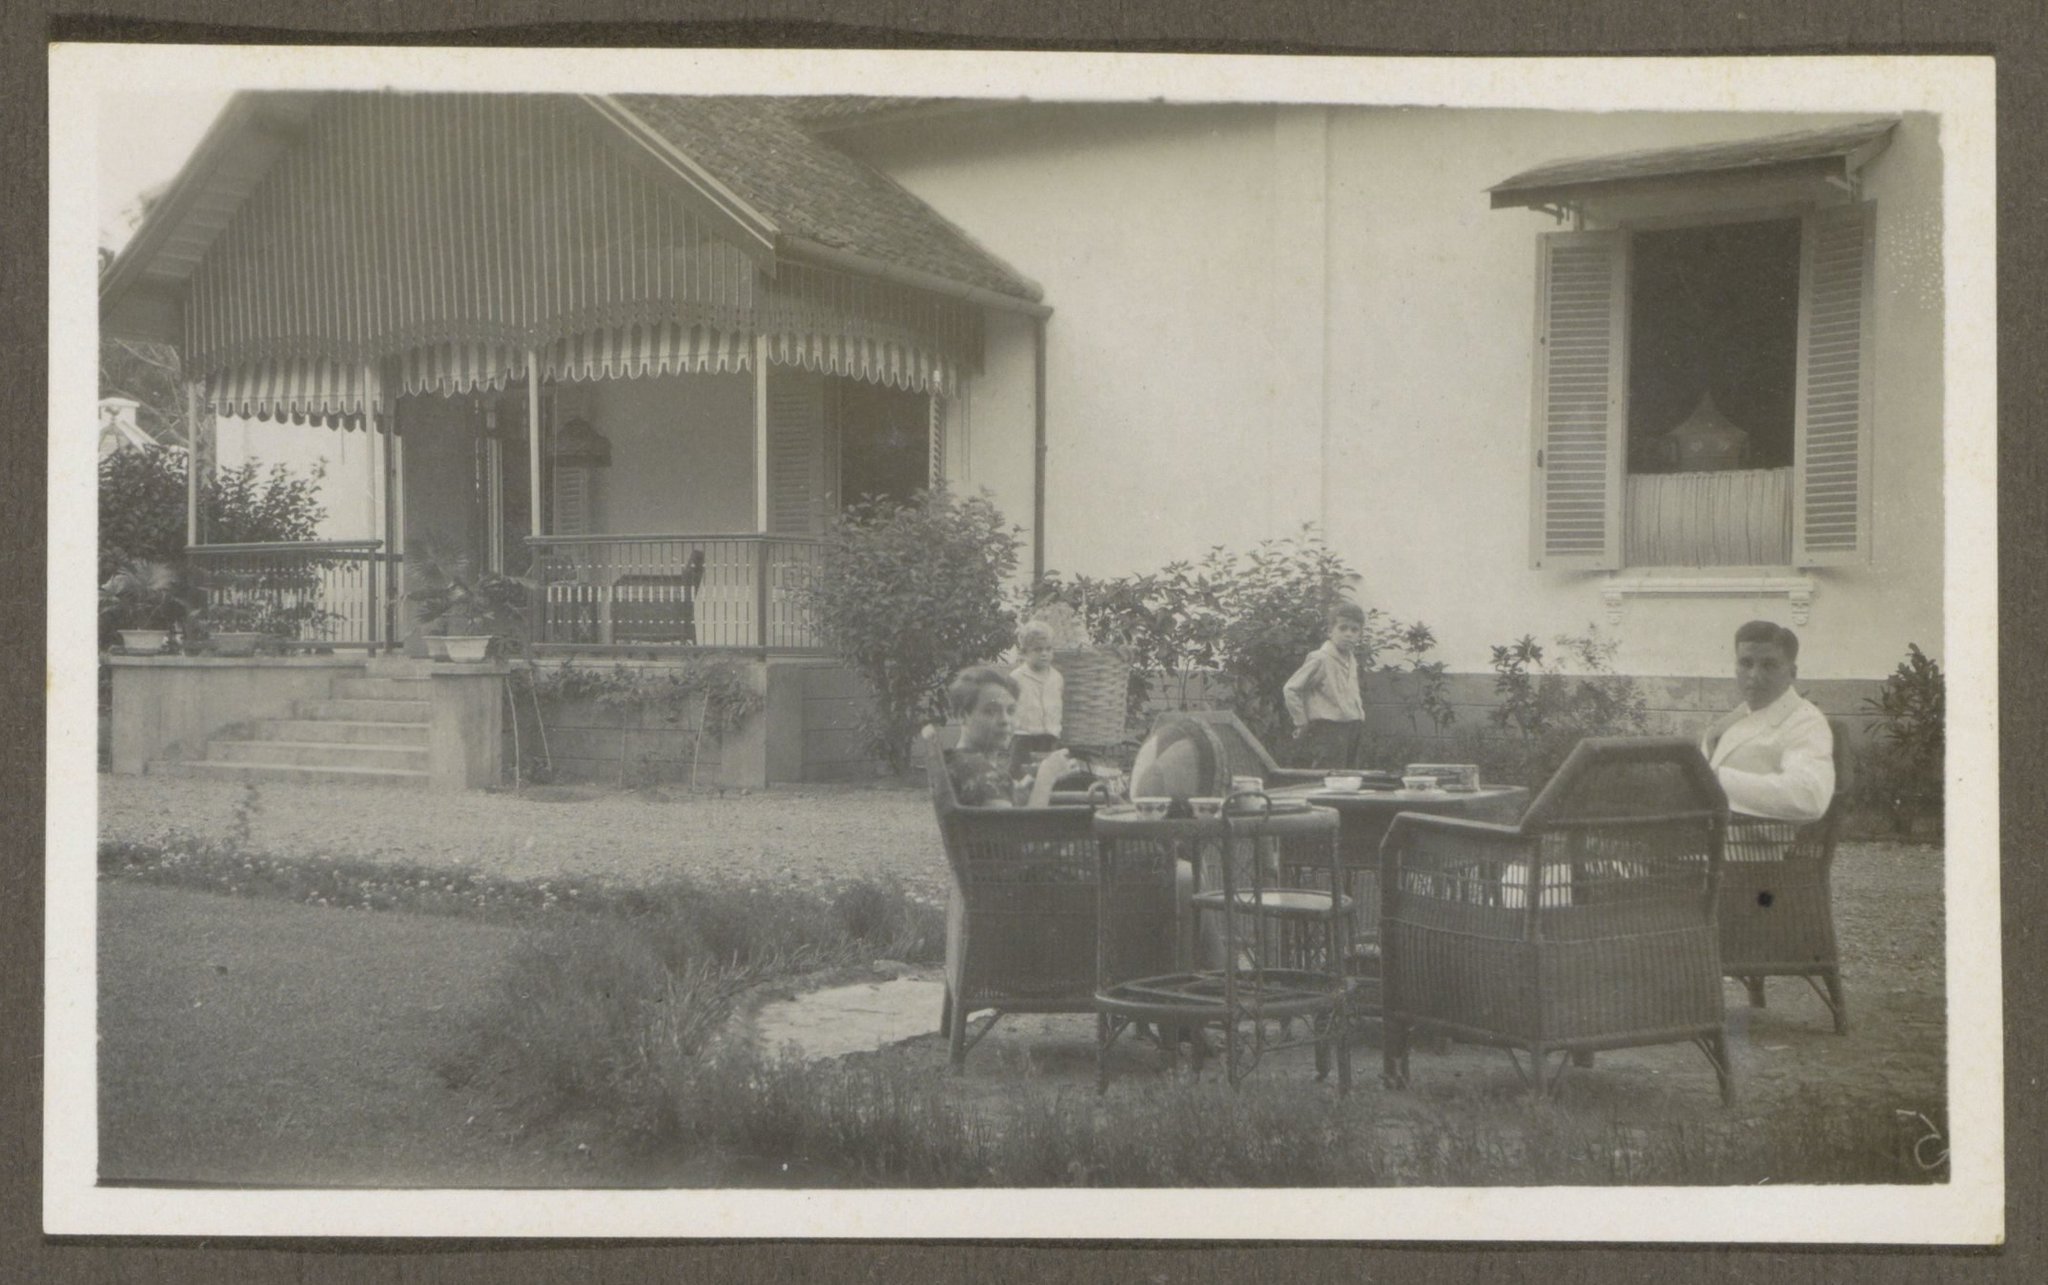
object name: photograph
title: Man en een vrouw met twee kinderen in een tuin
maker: Anonymous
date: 1920-1930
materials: photographic support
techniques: gelatin silver print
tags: garden, dutch east indies, the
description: Onderdeel van familiealbum Nederlands-Indië.